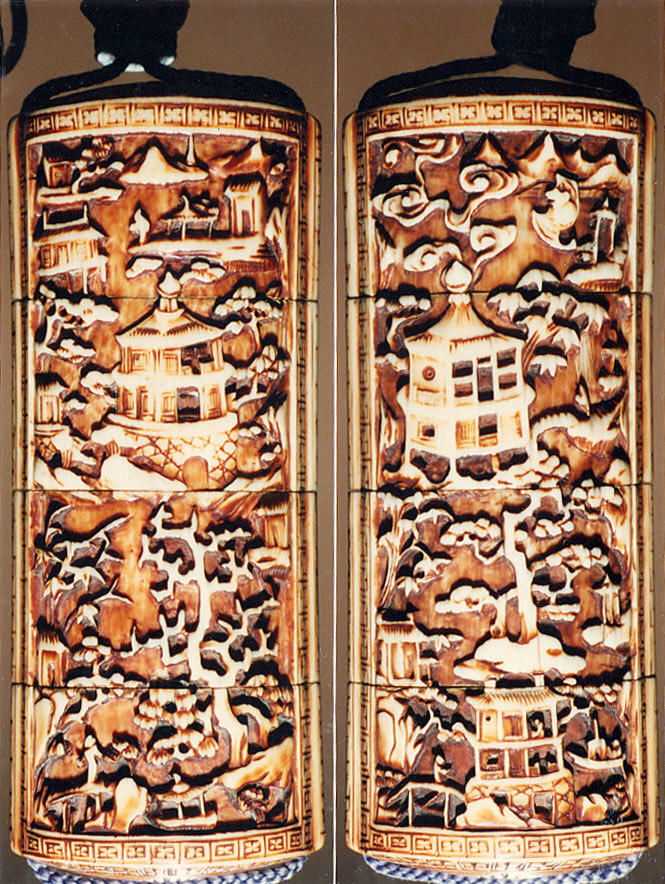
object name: inrō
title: Case (Inrō) with Design of Chinese-Style Landscape with Floral Band and Stylized Character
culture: japanese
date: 1801-1900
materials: ivory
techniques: carving, fundame, relief, stain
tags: landscapes